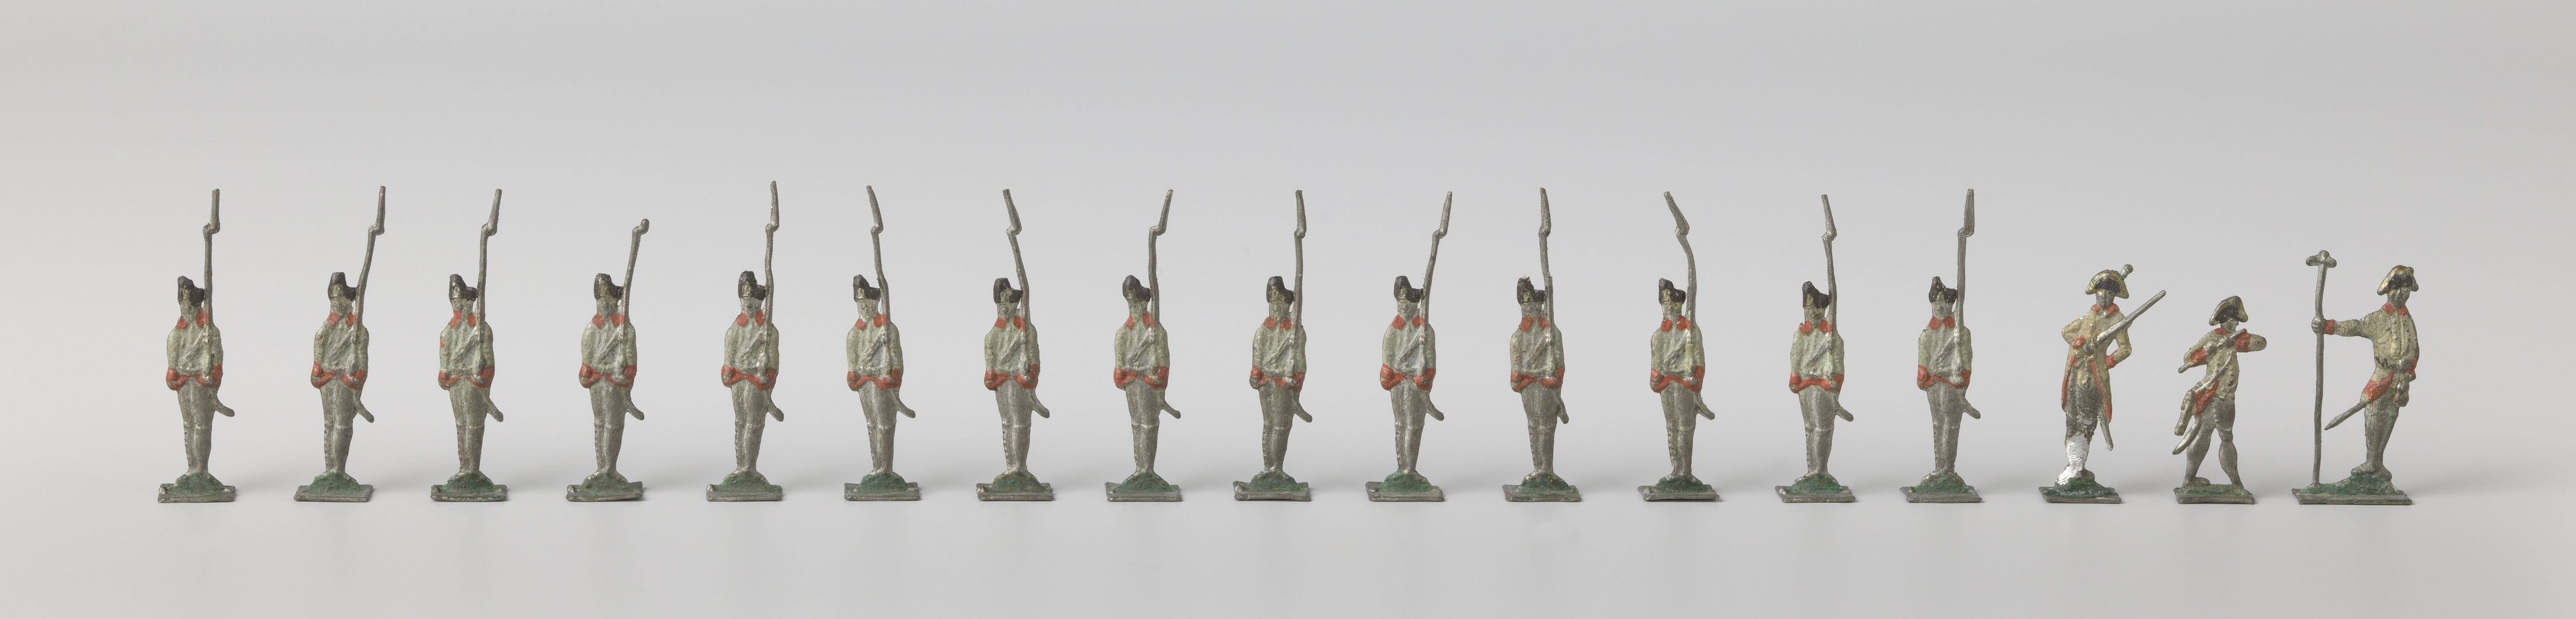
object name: miniature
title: Tinnen soldaatjes uit het einde van de 18de eeuw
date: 1775-1800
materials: tin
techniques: casting, polychromy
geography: germany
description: Collectie tinnen figuurtjes, bestaande uit 14 soldaatjes in houding met geweer met bajonet aan de schouder, één pijper, één vaandrig (vaandel afgebroken), en één officier. Gekleurd in wit, rood en zwart.